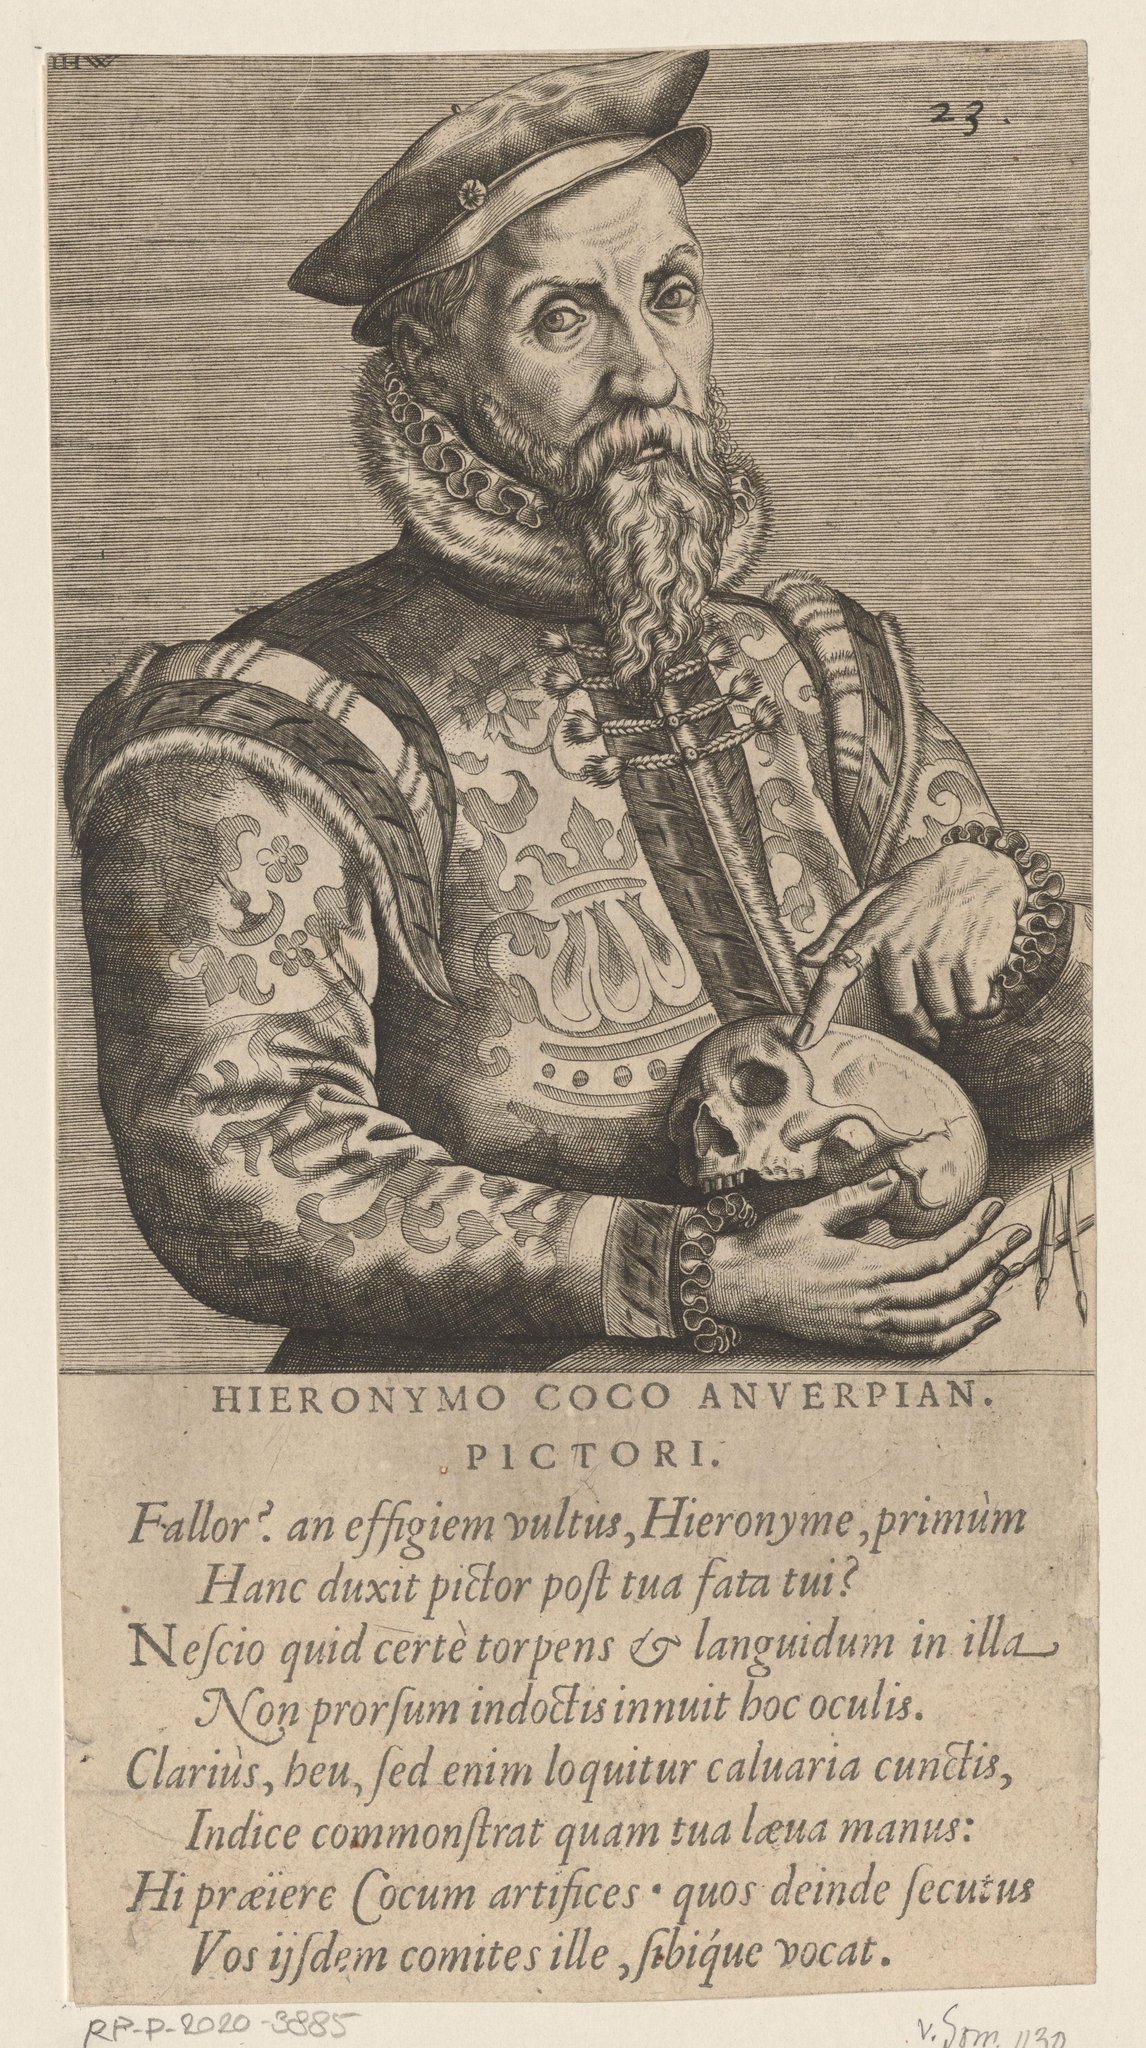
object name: print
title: Portretten van schilders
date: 1572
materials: paper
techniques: engraving, letterpress printing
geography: antwerp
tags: antwerp, print maker, publisher, hieronymus cock, (human) skull, historical persons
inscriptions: workshop stamp: Lugt 2165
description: De serie is uitgegeven door de weduwe van Hieronymus Cock in 1572.